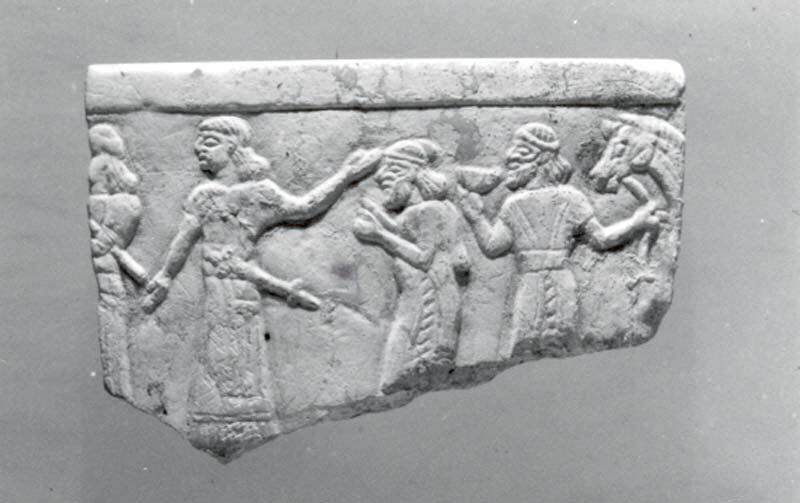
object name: bowl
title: Bowl fragment with a procession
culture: assyrian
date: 900-801 BCE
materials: stone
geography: mesopotamia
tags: animals,men